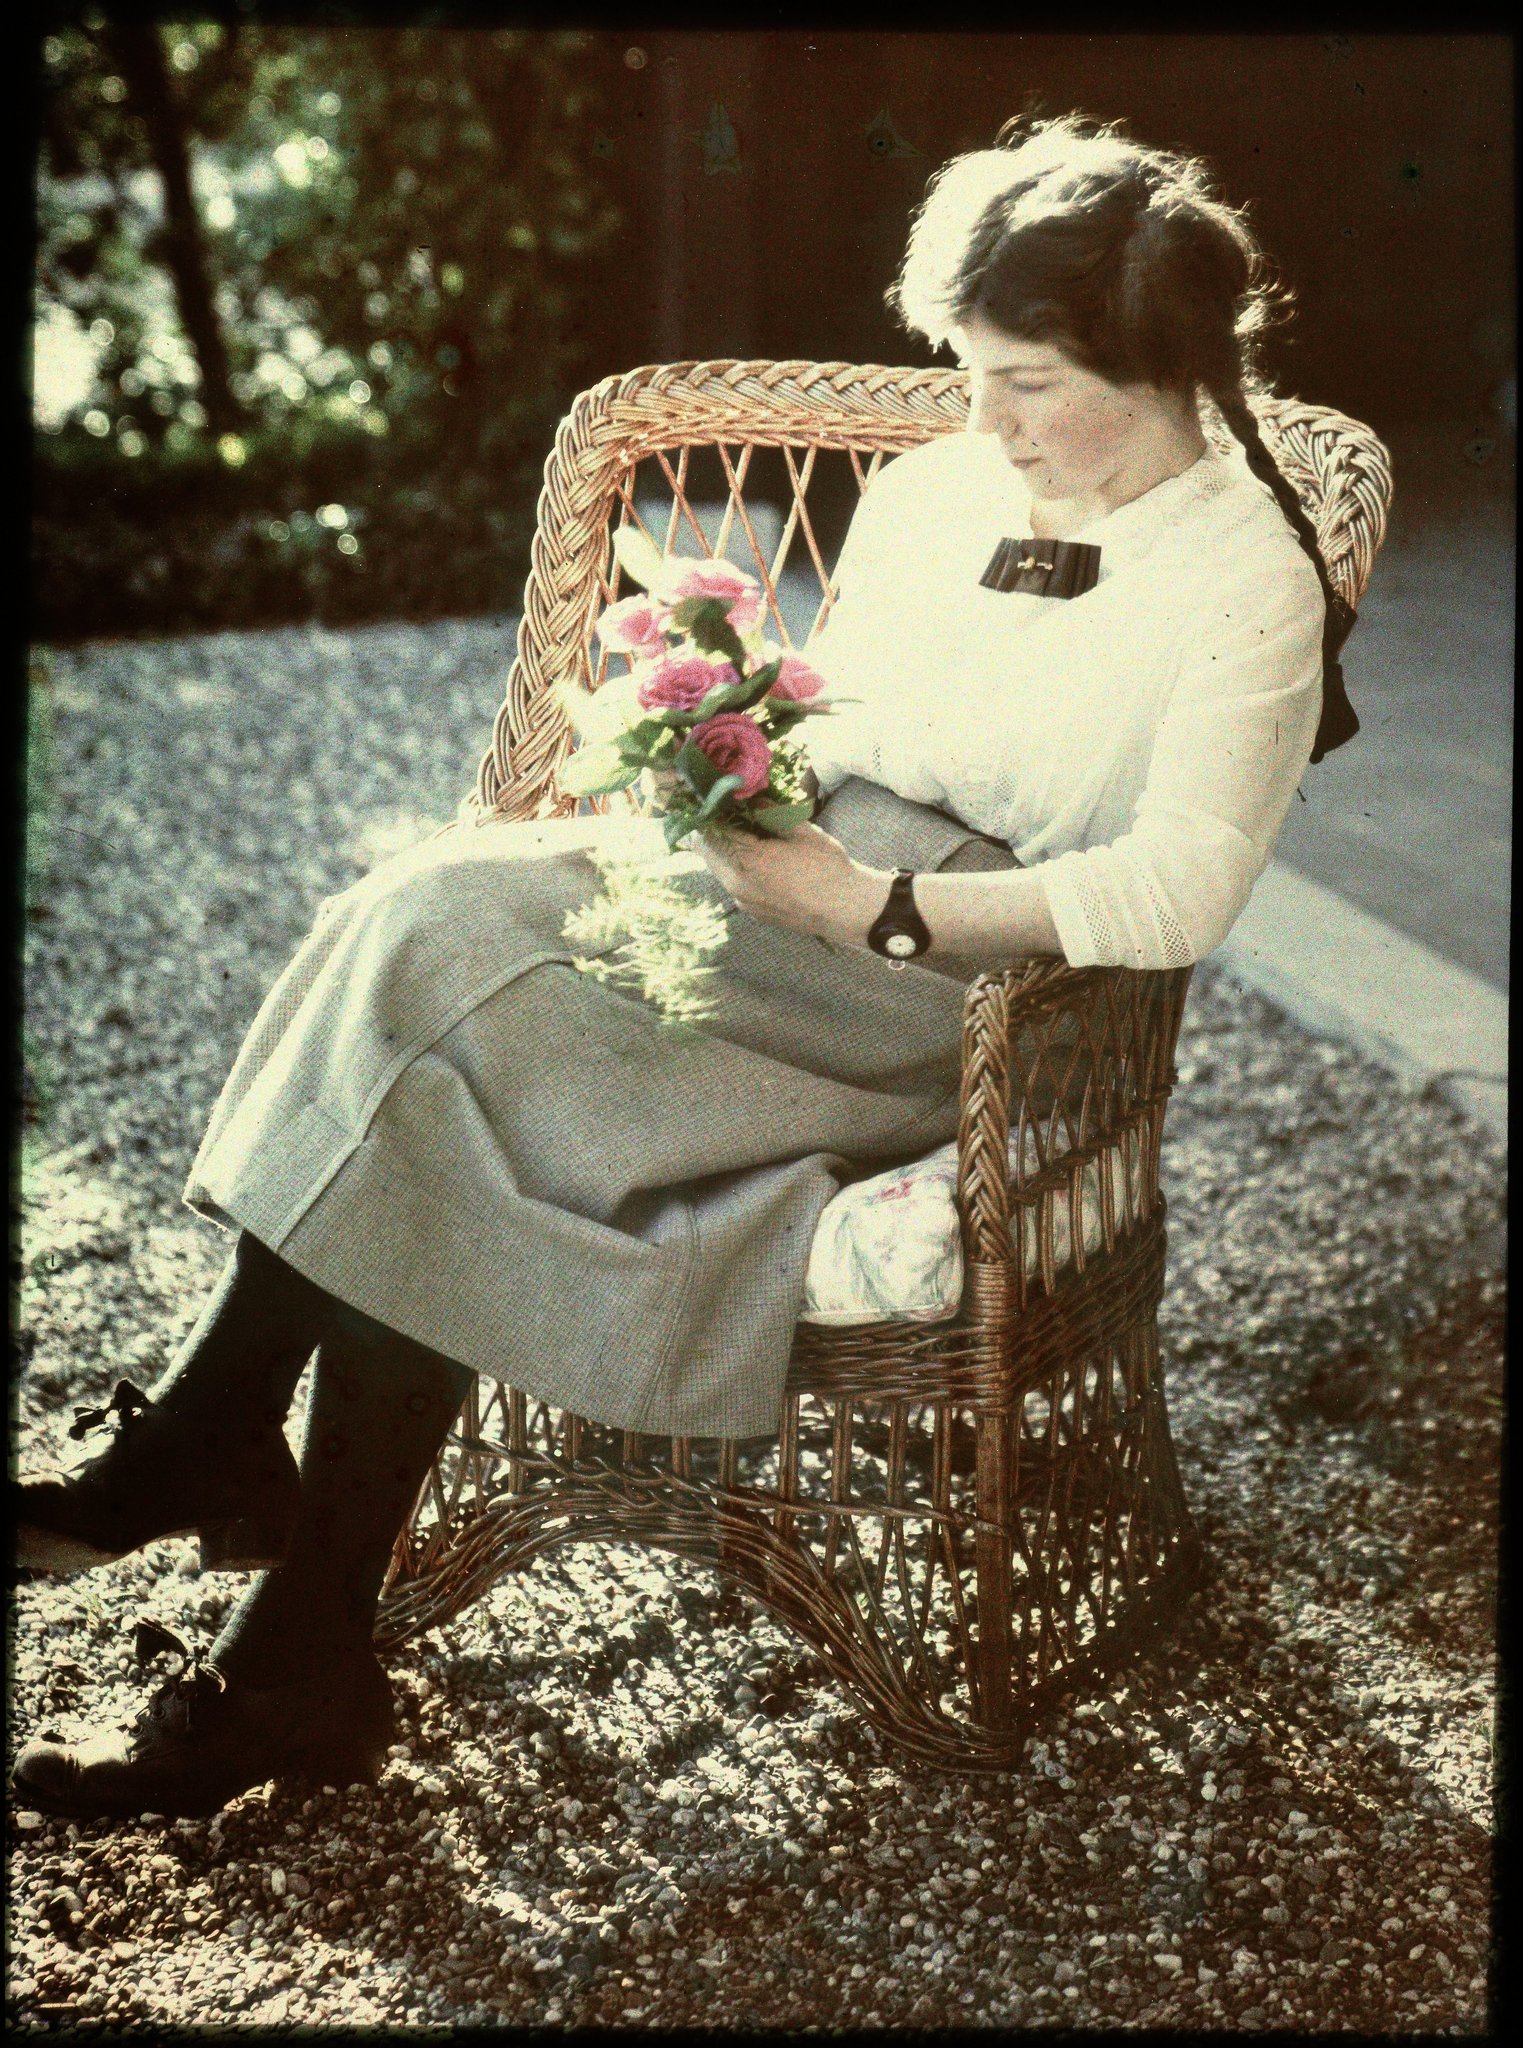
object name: color slide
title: Jonge vrouw (gekleed in een witte blouse en een grijze rok en met vlechten in het haar) zittend in een stoel op grint, met een bosje bloemen in haar handen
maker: adolphe burdet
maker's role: fotograaf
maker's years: 1860-1940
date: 1907-1930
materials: glass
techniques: autochrome process, slide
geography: netherlands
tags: elise burdet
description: Jonge vrouw (gekleed in een witte blouse en een grijze rok en met vlechten in het haar) zittend in een stoel op grint, met een bosje bloemen in haar handen.